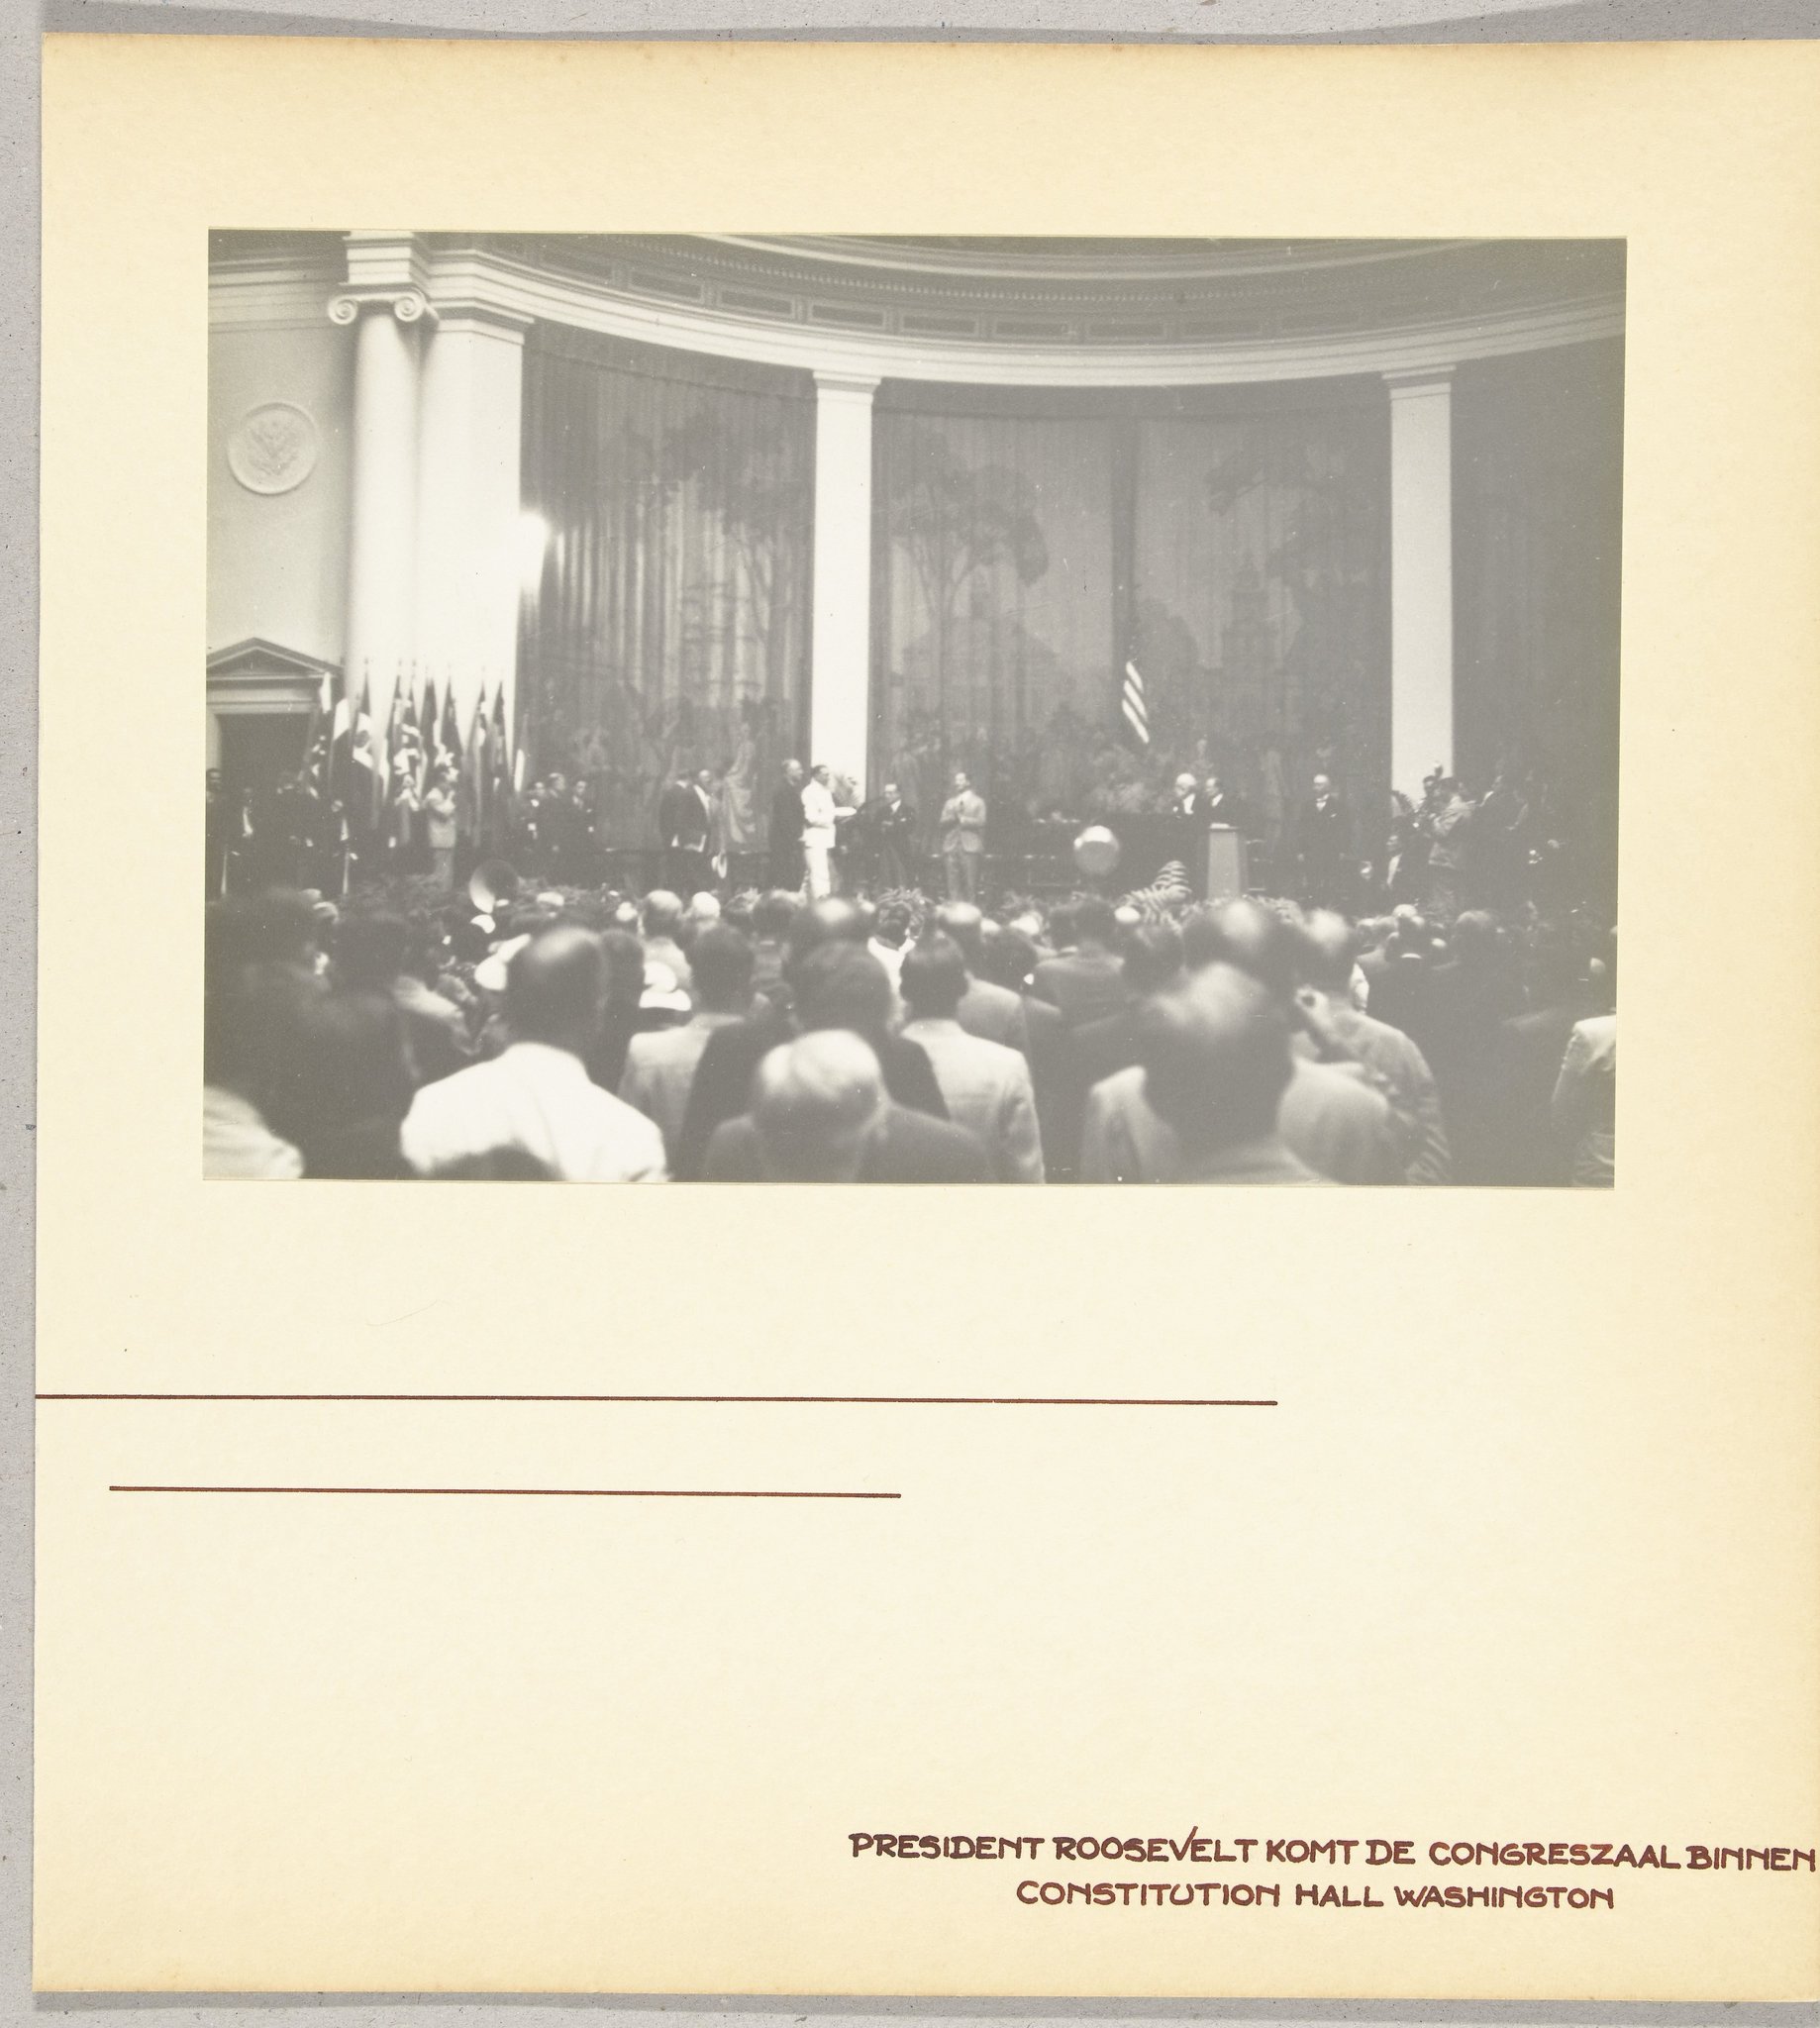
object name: photograph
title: Toespraak van de Amerikaanse president Franklin D. Roosevelt tijdens de Third World Power Conference, Constitution Hall, Washington DC, Verenigde Staten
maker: wouter cool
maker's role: engineer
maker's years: 1877-1947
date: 1936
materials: cardboard, paper, photographic support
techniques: gelatin silver print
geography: united states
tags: president ~ head of republic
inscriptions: title: ‘PRESIDENT ROOSEVELT KOMT DE CONGRESZAAL BINNEN / CONSTITUTION HALL WASHINGTON’